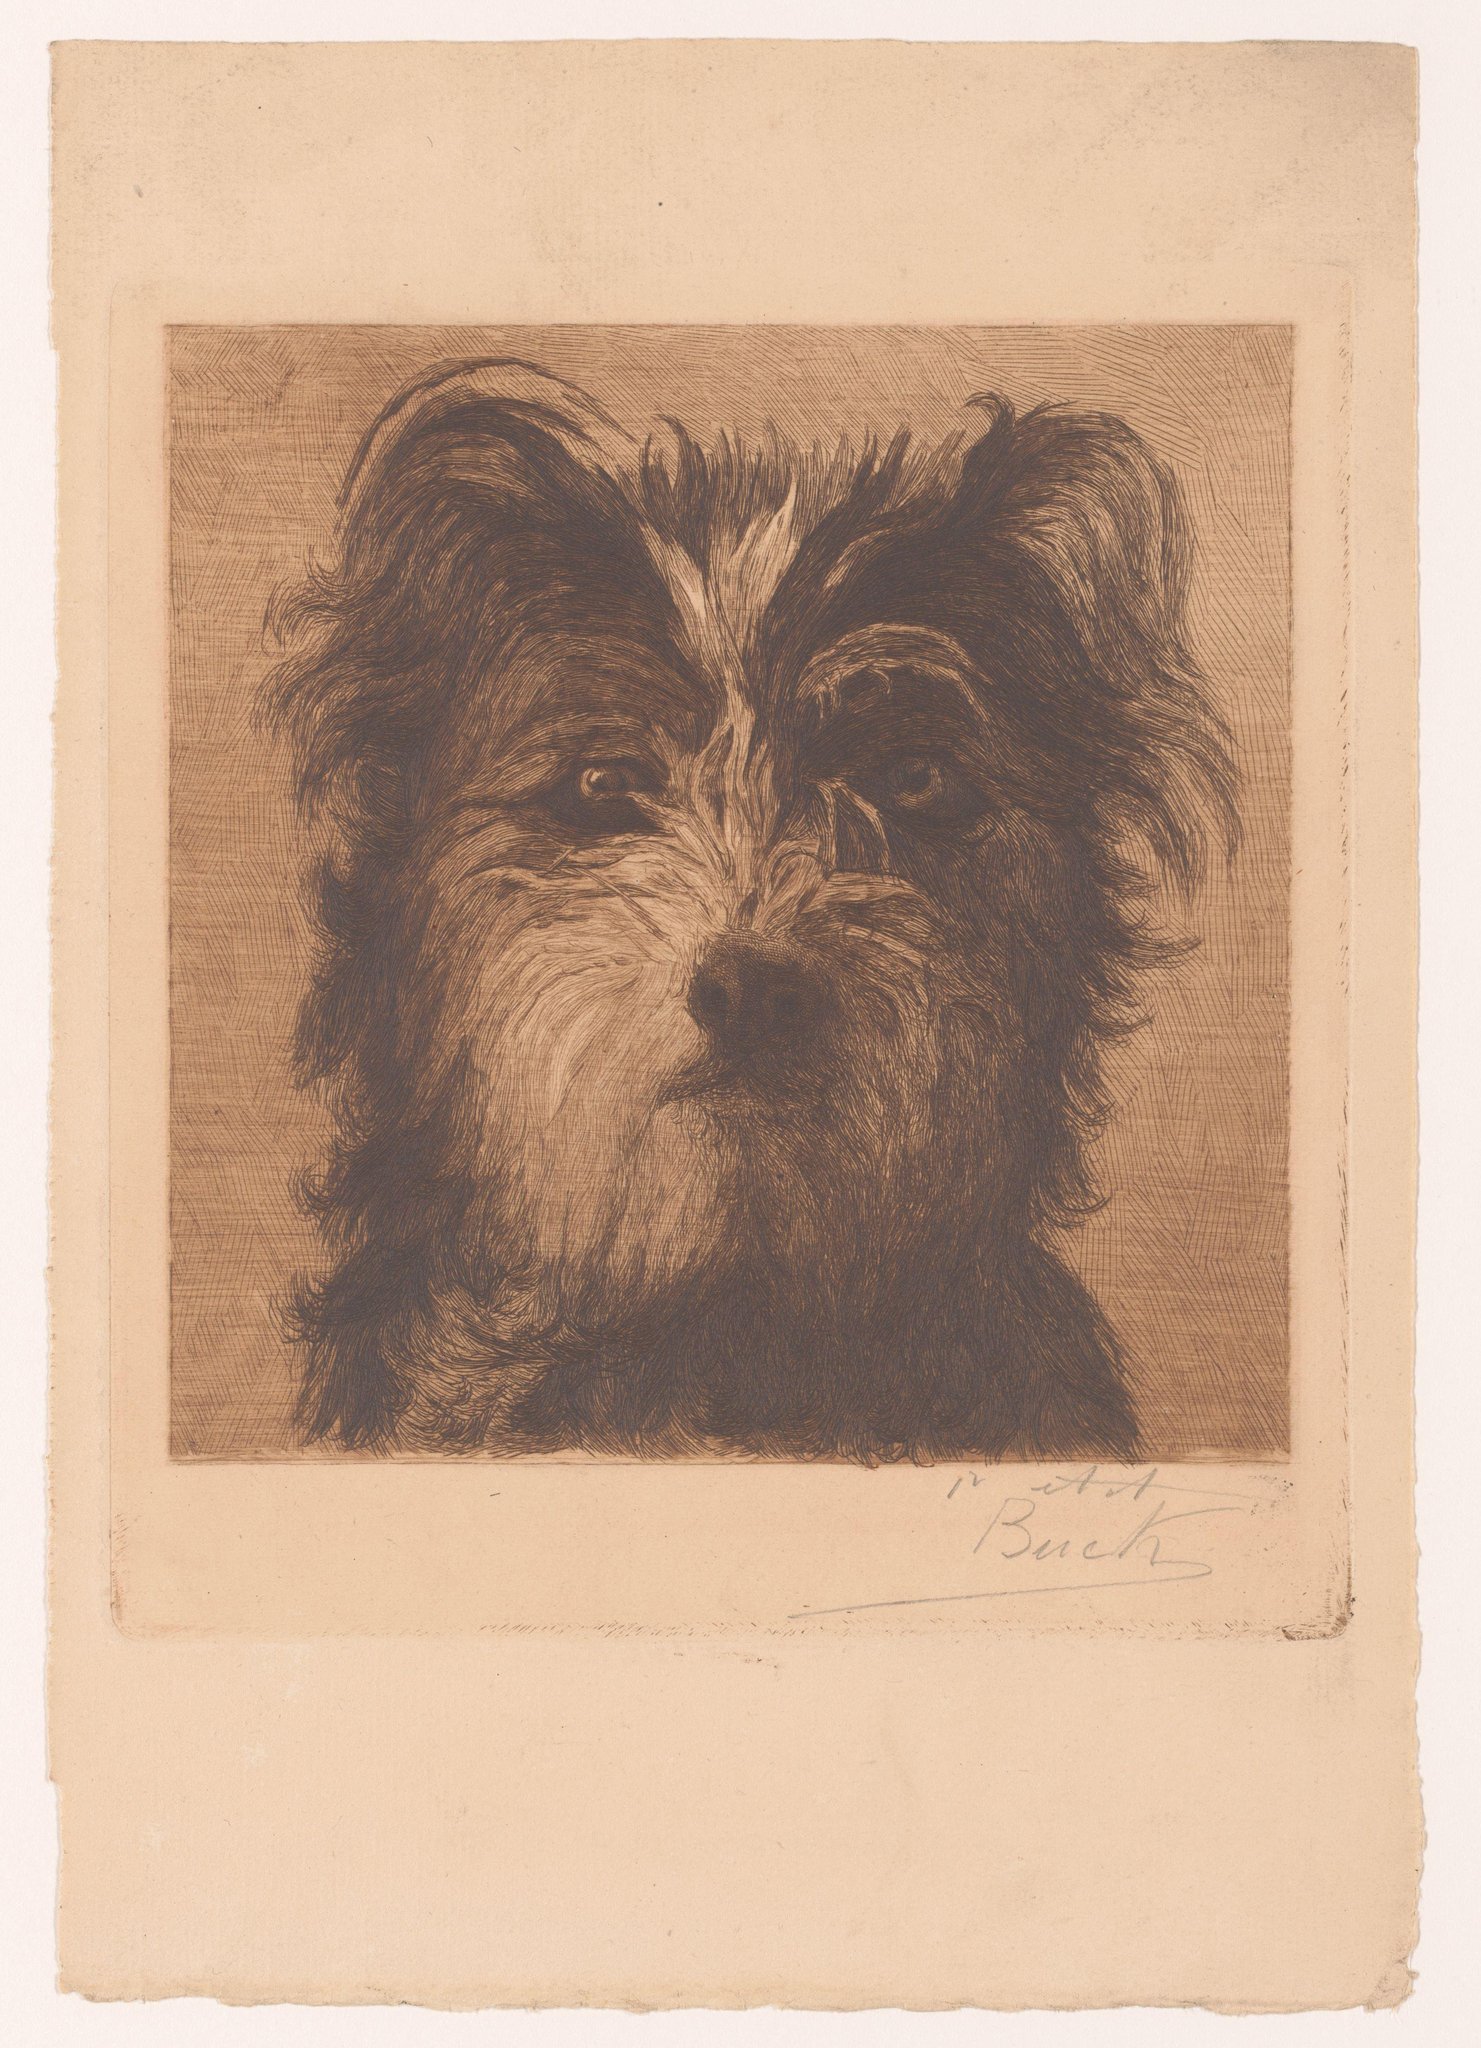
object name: print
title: Hondenkop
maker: florimond buyck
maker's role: print maker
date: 1870-1909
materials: paper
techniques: etching, intaglio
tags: dog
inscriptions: collector's mark: Lugt 2228, annotation: ‘1e etat’, annotation: ‘tete de chien d'apres Mr. Danse’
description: Sterfdatum prentmaker onbekend. Derhalve is voor bepaling van de rechten van dit object de verwervingsdatum aangehouden.